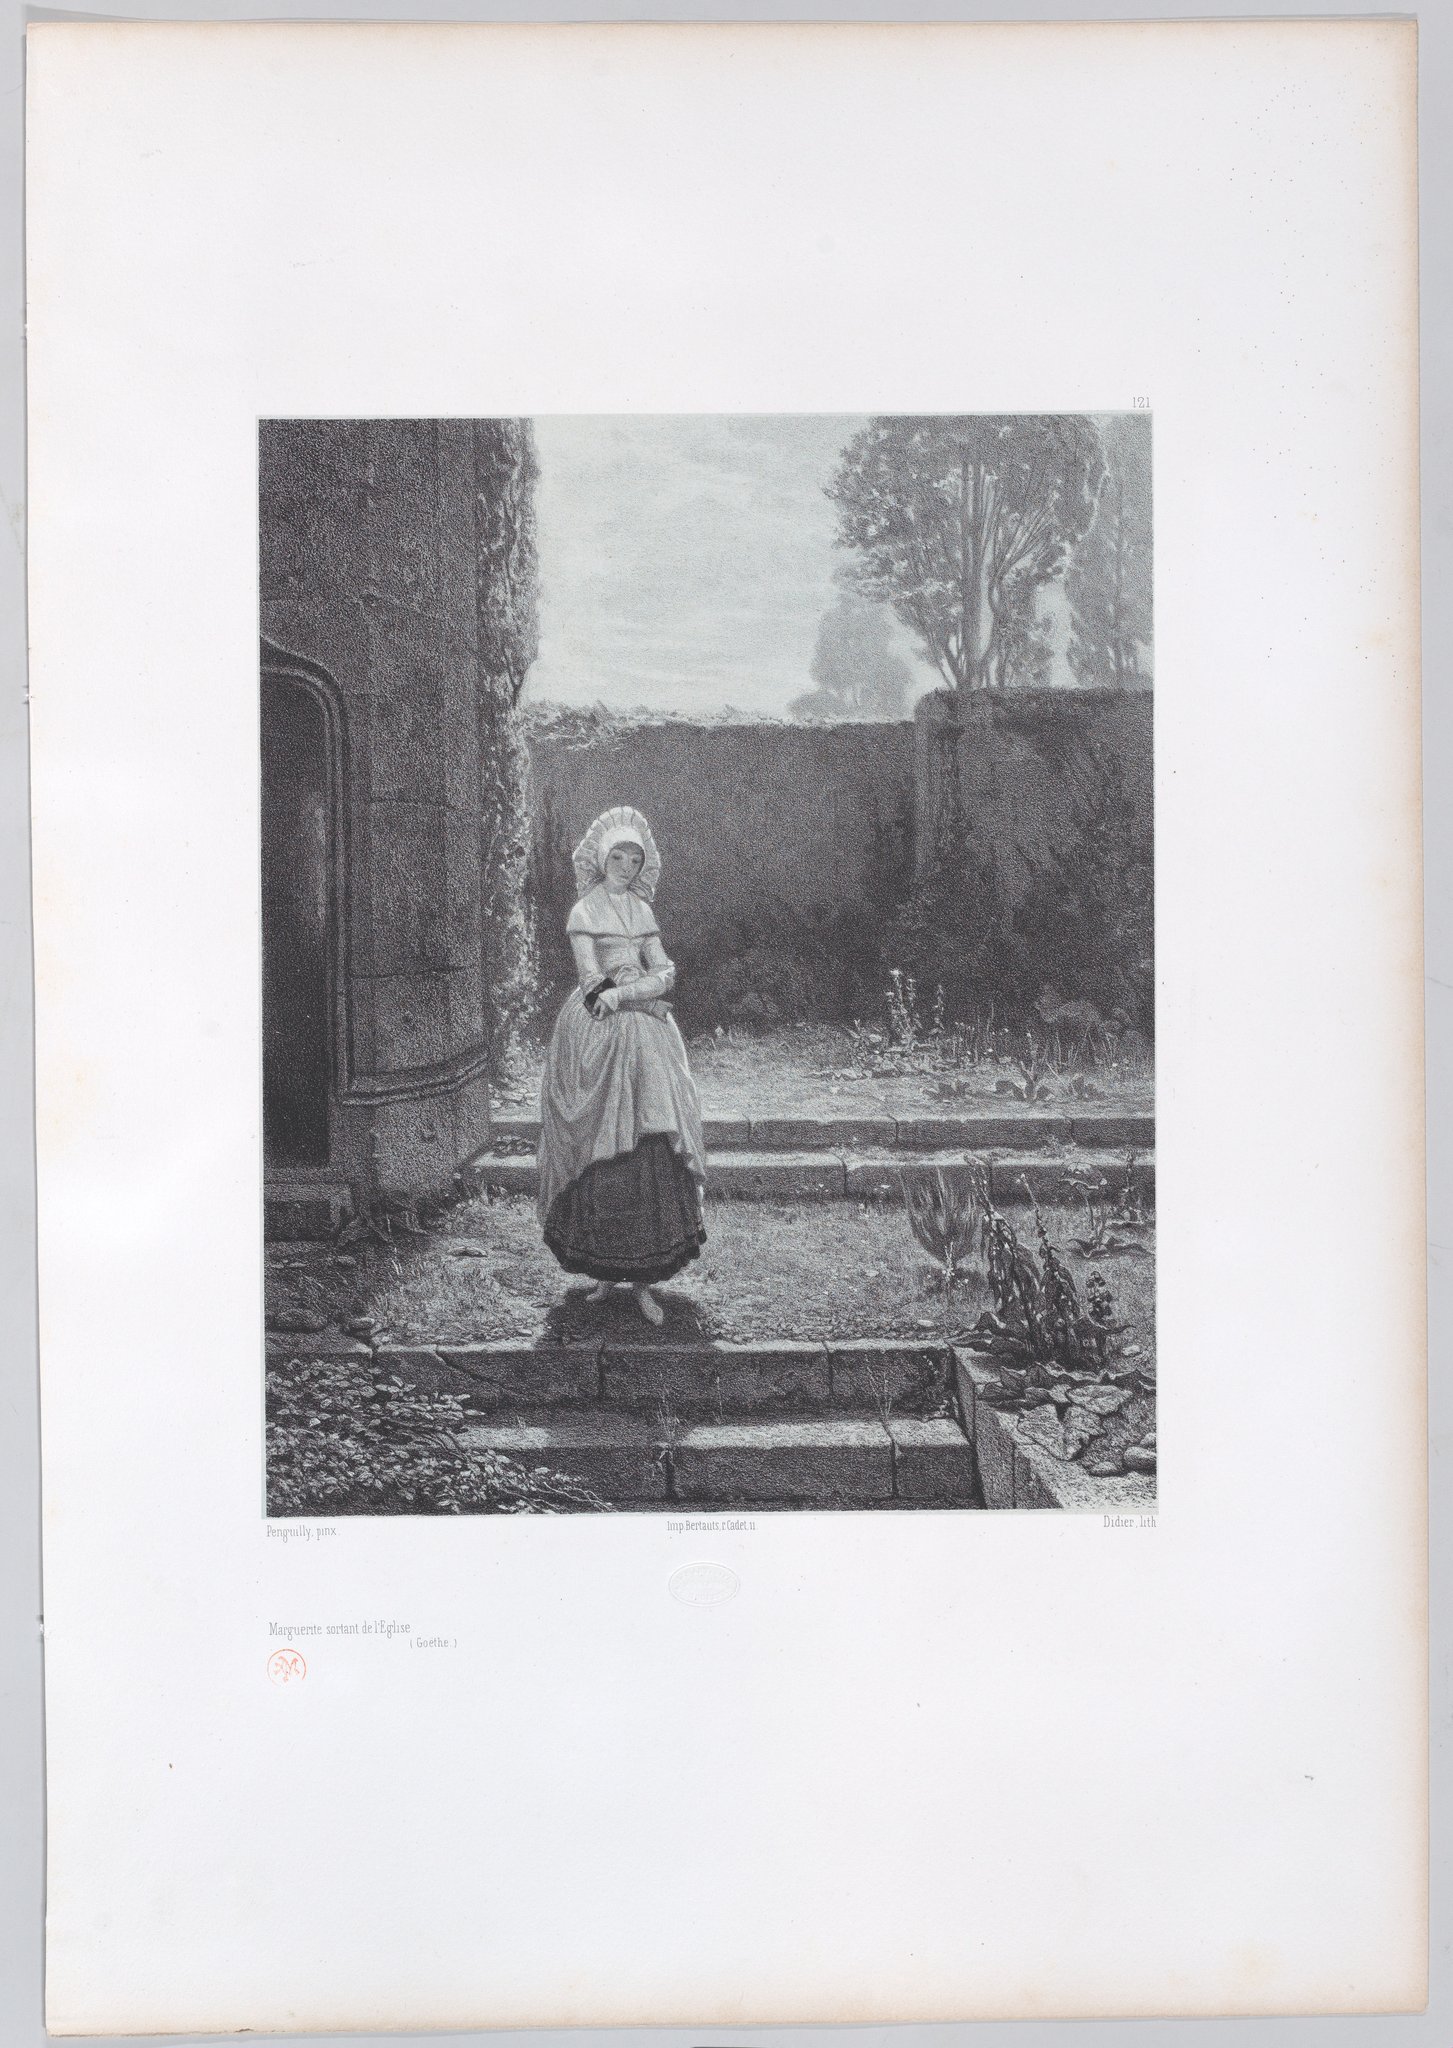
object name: print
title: Marguerite sortant de l'Eglise (Goëthe)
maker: jules didier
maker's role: artist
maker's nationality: french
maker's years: 1831-1914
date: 1850-1914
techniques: lithograph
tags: women